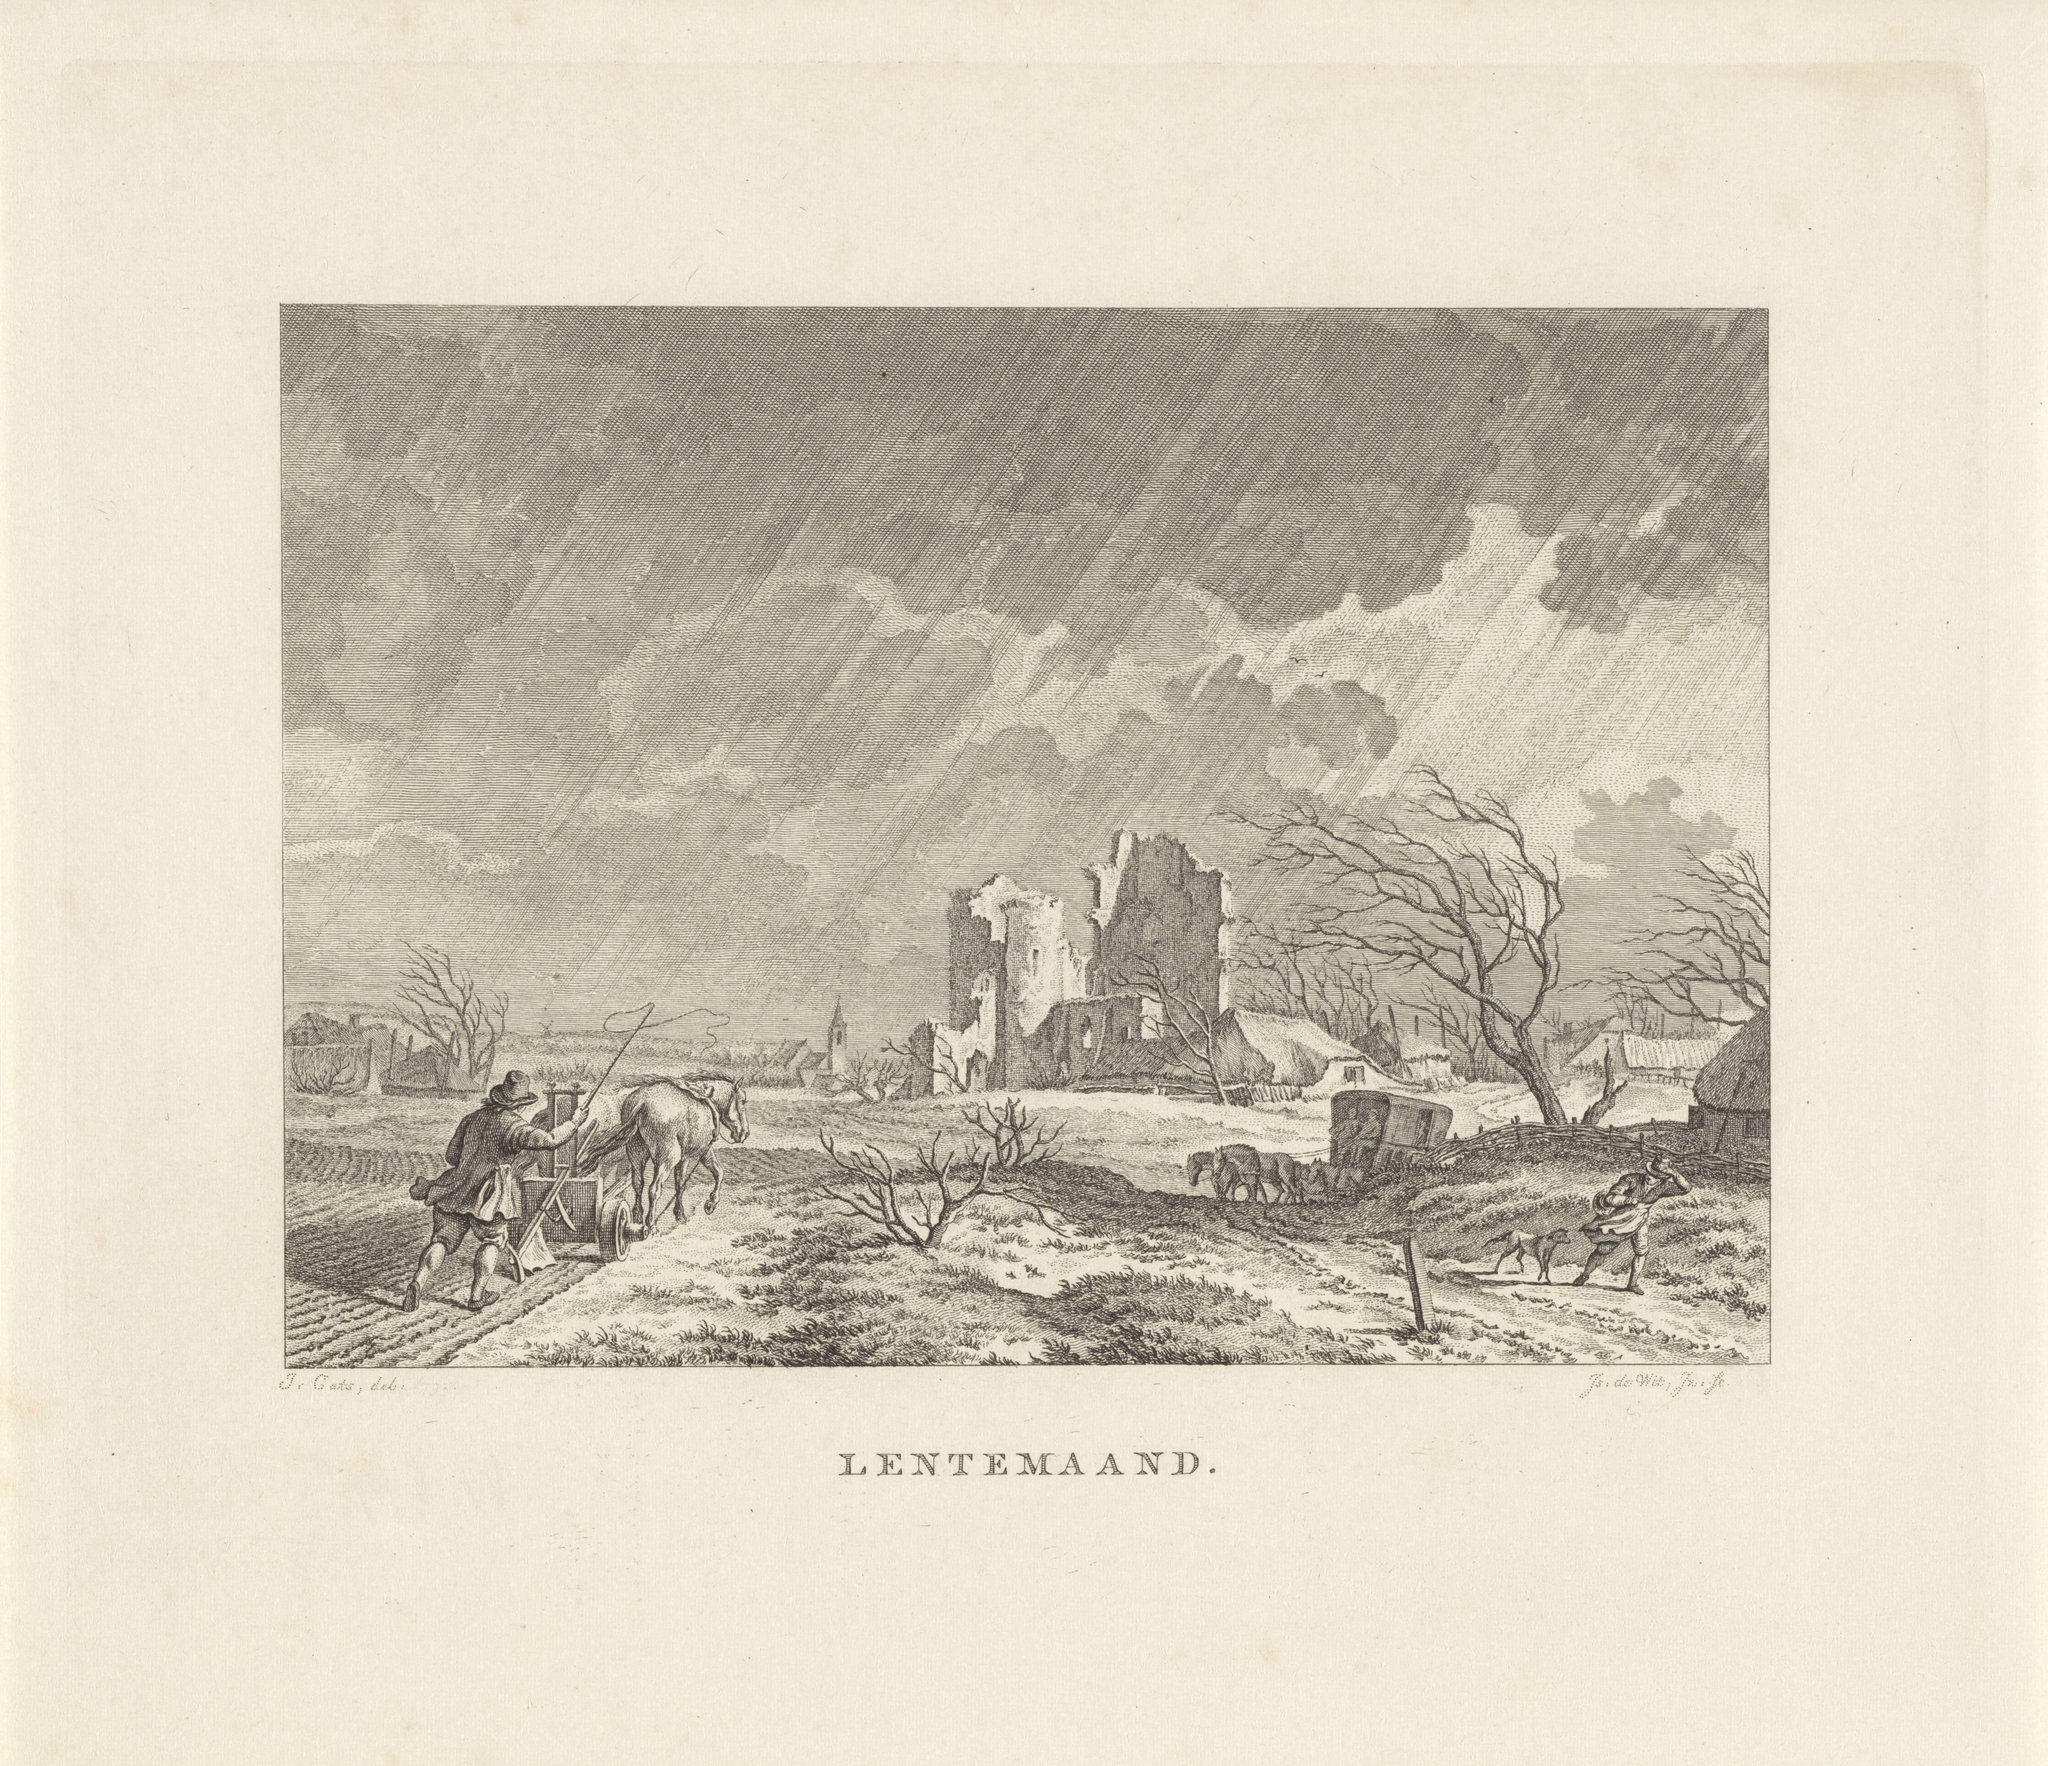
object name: print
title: Landschap met een ruïne en een ploegende boer in de regen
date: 1807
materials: paper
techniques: etching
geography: haarlem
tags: downpour, rain shower, march and its 'labours' (+ with scenes showing human occupations ~ seasons and months), landscape with ruins, ploughing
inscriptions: collector's mark: Lugt 2228